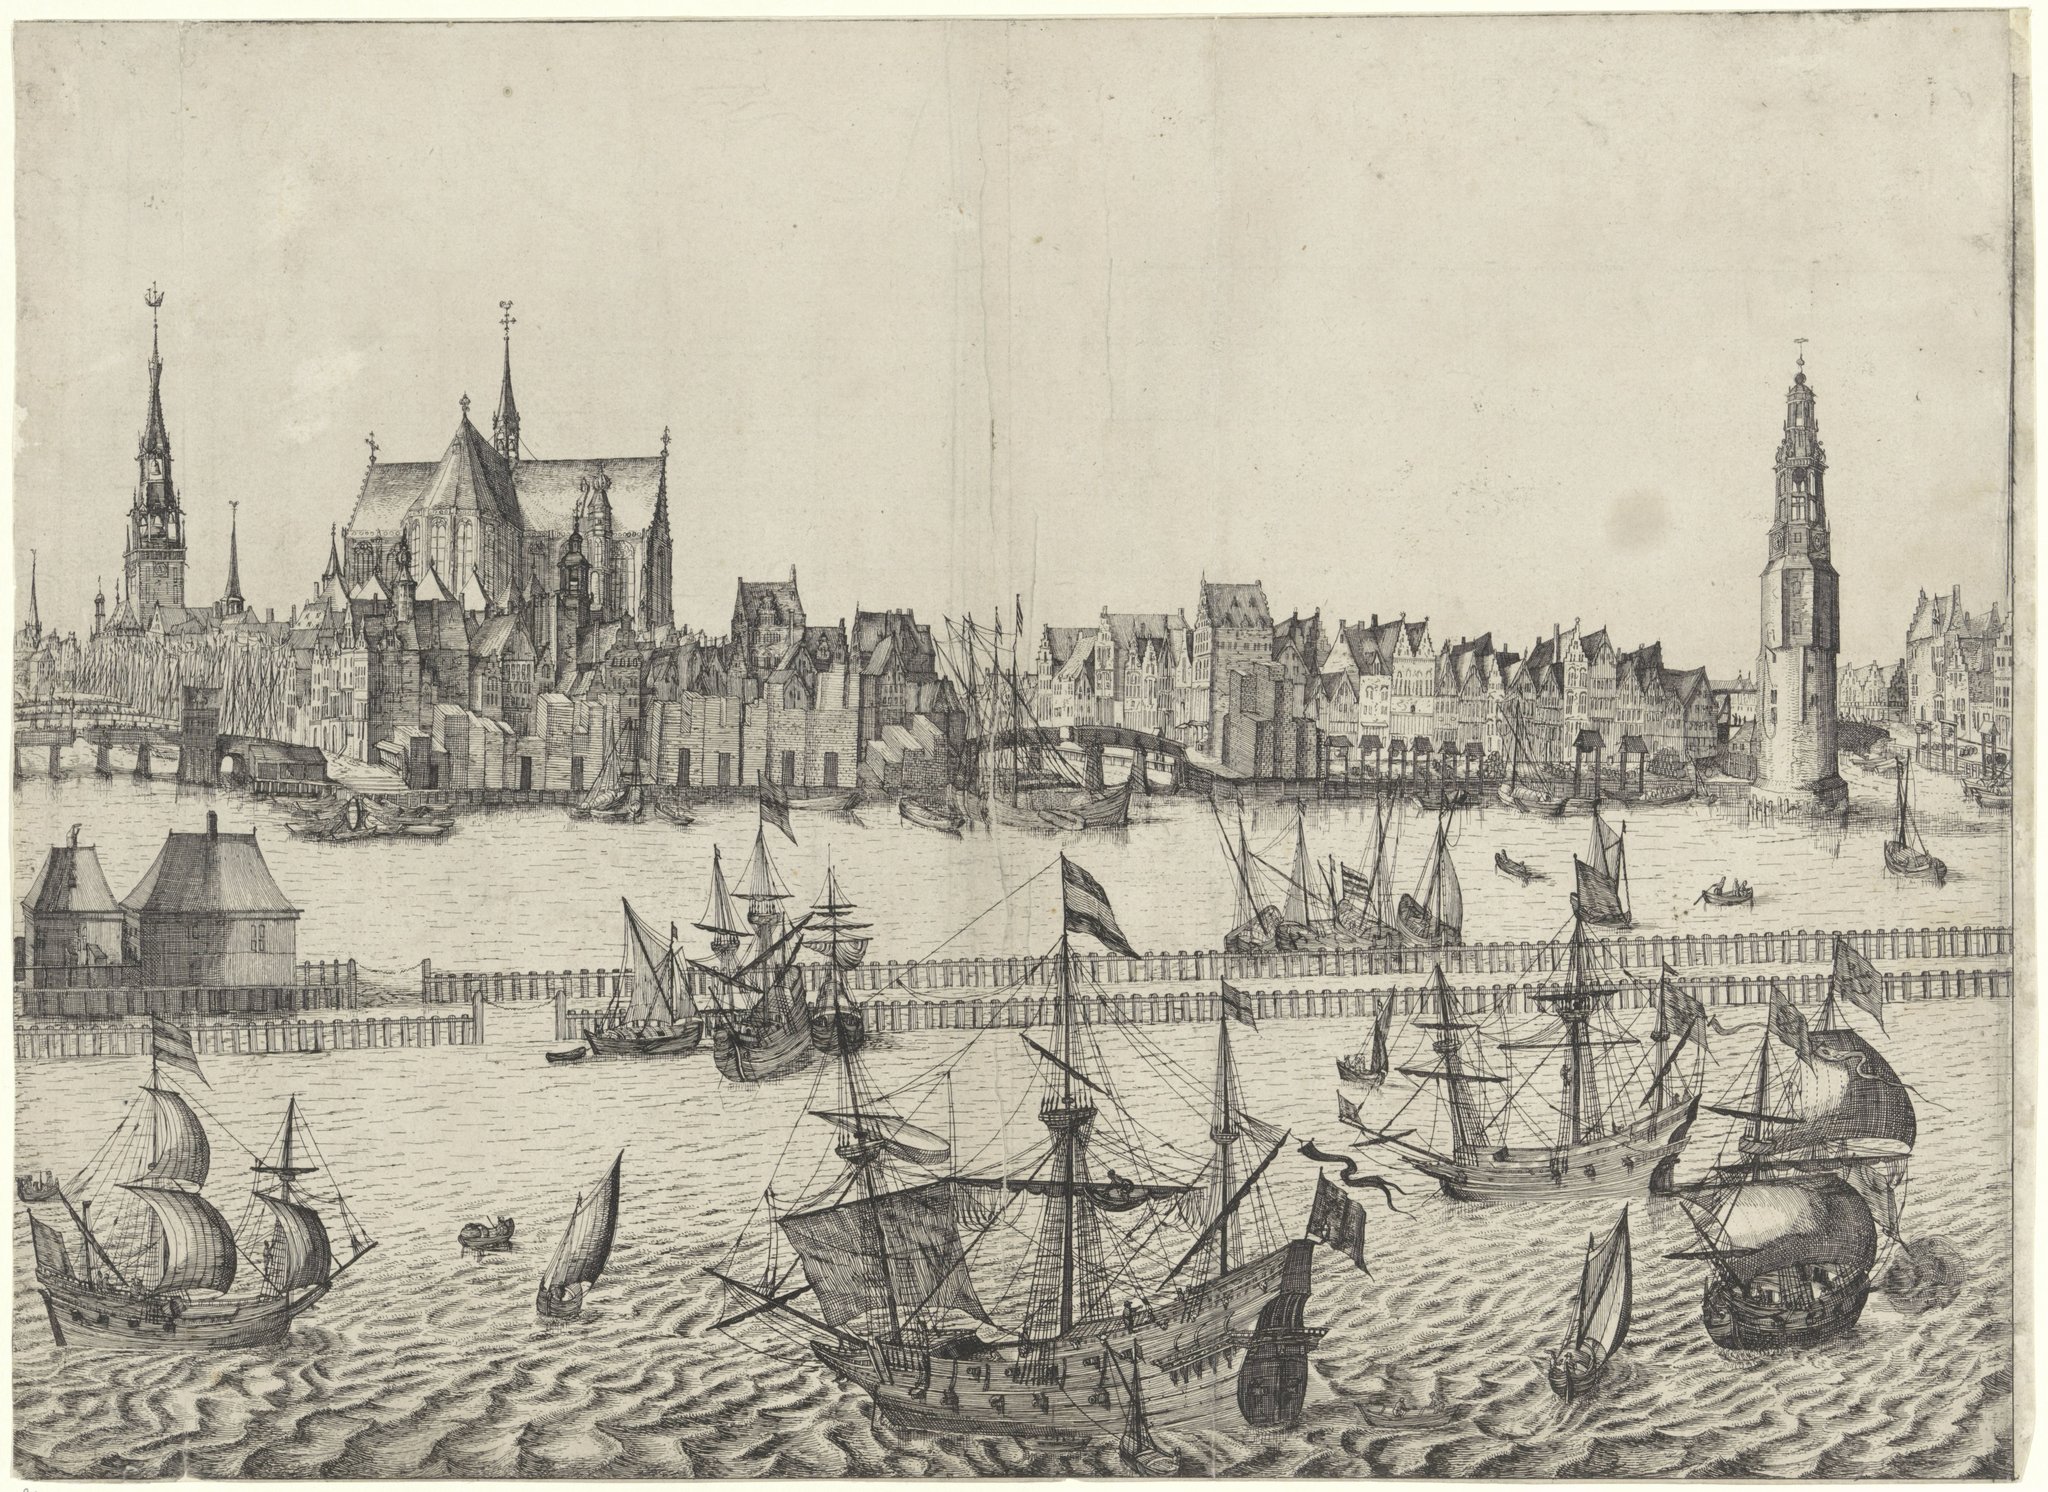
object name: print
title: Gezicht op Amsterdam, vanaf het IJ ( plaat III)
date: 1612-1652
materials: paper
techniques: etching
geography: amsterdam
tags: farmers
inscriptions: collector's mark: Lugt 2228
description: Plaat rechtsmidden van 'Gezicht op Amsterdam' met een gedeelte van Amsterdam, gezien vanaf het IJ. Op het IJ varen verschillende schepen en bootjes. Links op de achtergrond het Oude stadhuis op de Dam en de Nieuwe kerk en rechts de Haringpakkerstoren.